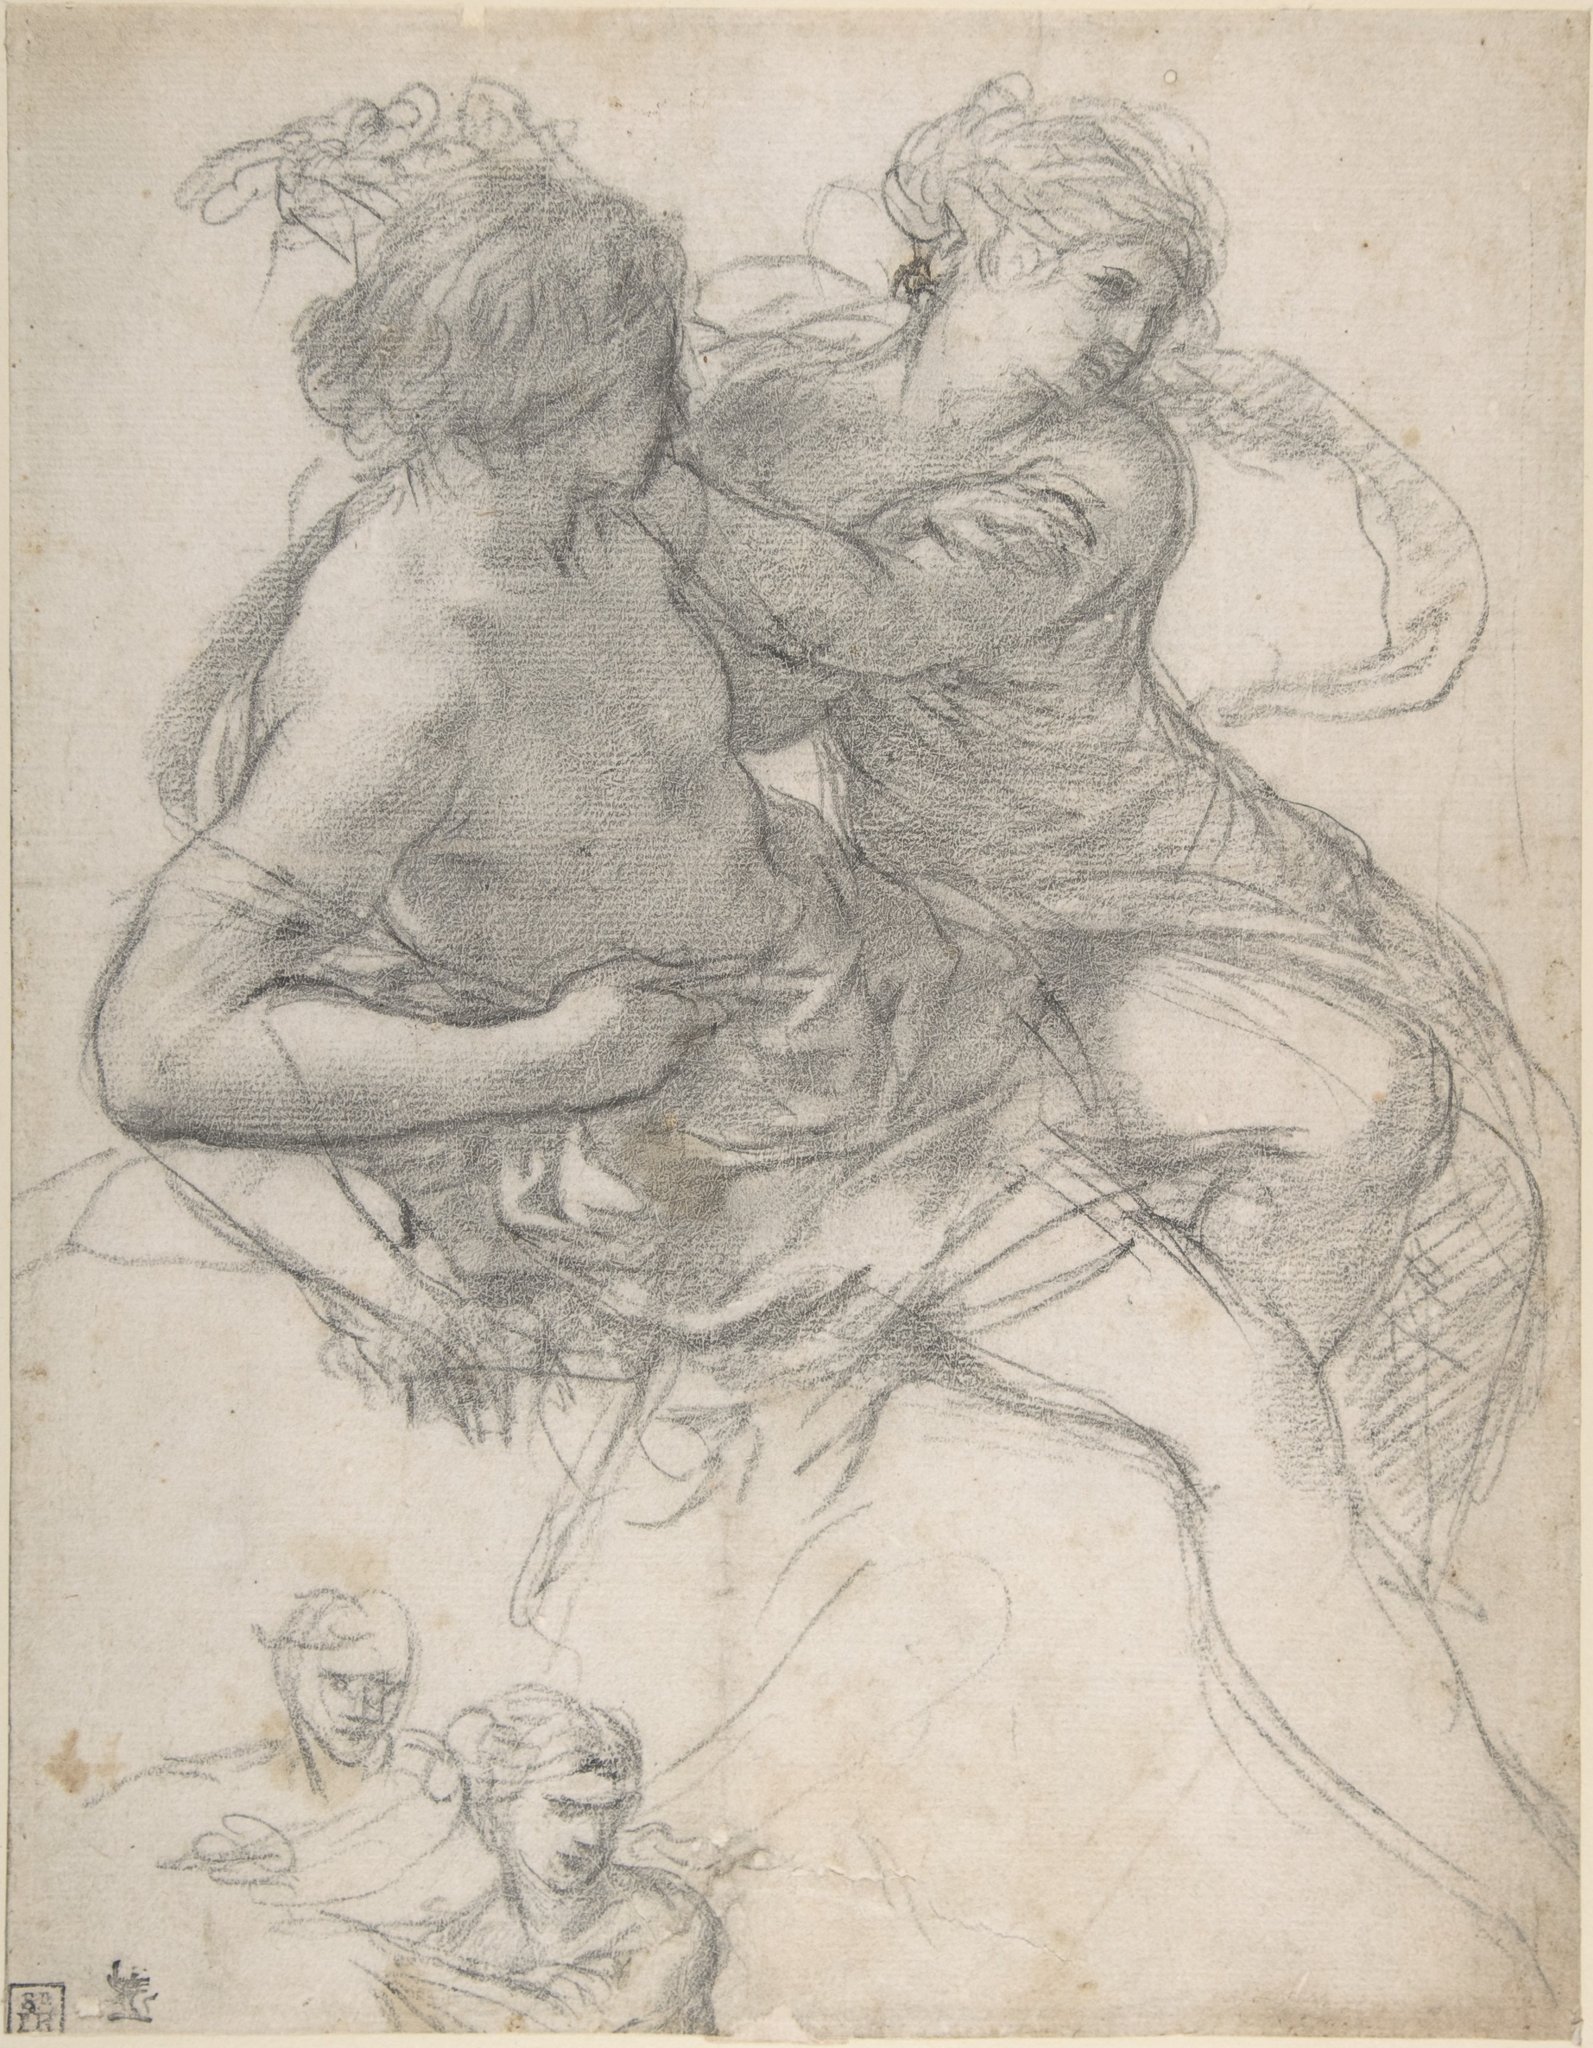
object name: drawing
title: Study of Two Figures for the Age of Gold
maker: pietro da cortona (pietro berrettini)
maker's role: artist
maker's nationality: italian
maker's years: 1596-1669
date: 1637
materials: chalk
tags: men,women